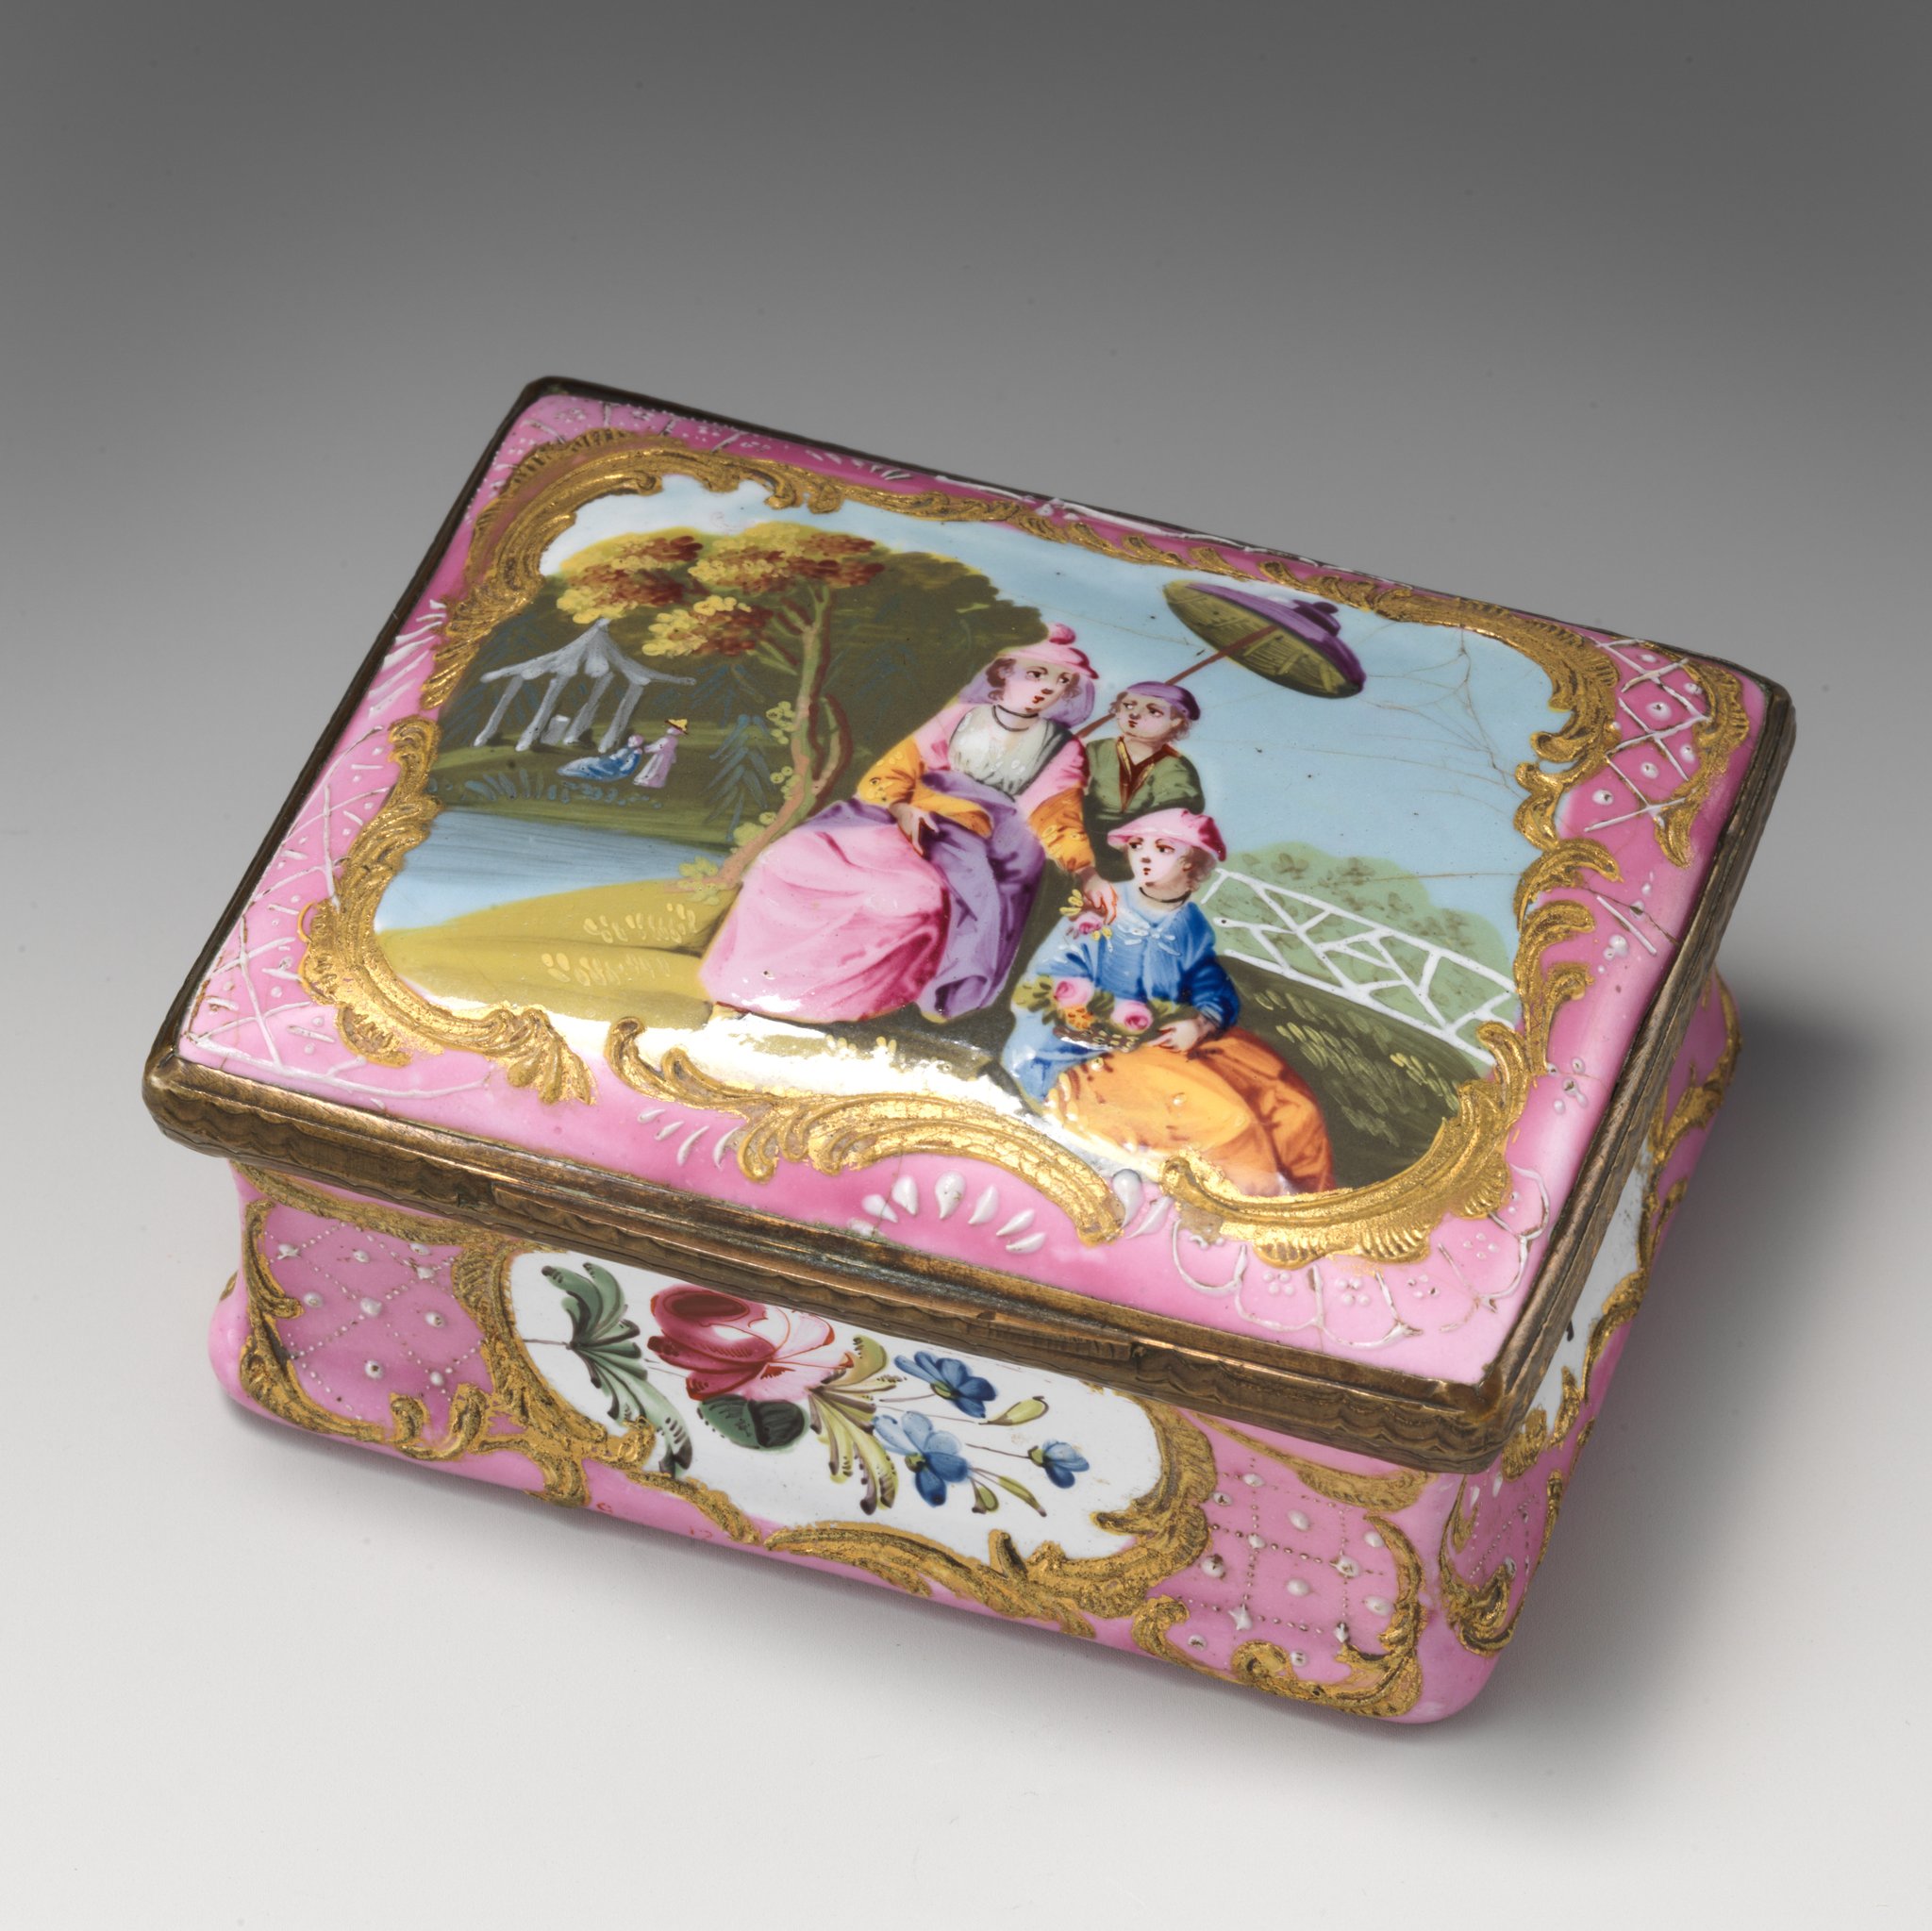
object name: snuffbox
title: Snuffbox with chinoiserie scene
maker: jacques gabriel huquier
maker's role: engraver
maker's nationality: french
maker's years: 1730-1805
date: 1765-1770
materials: copper, enamel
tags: women,flowers